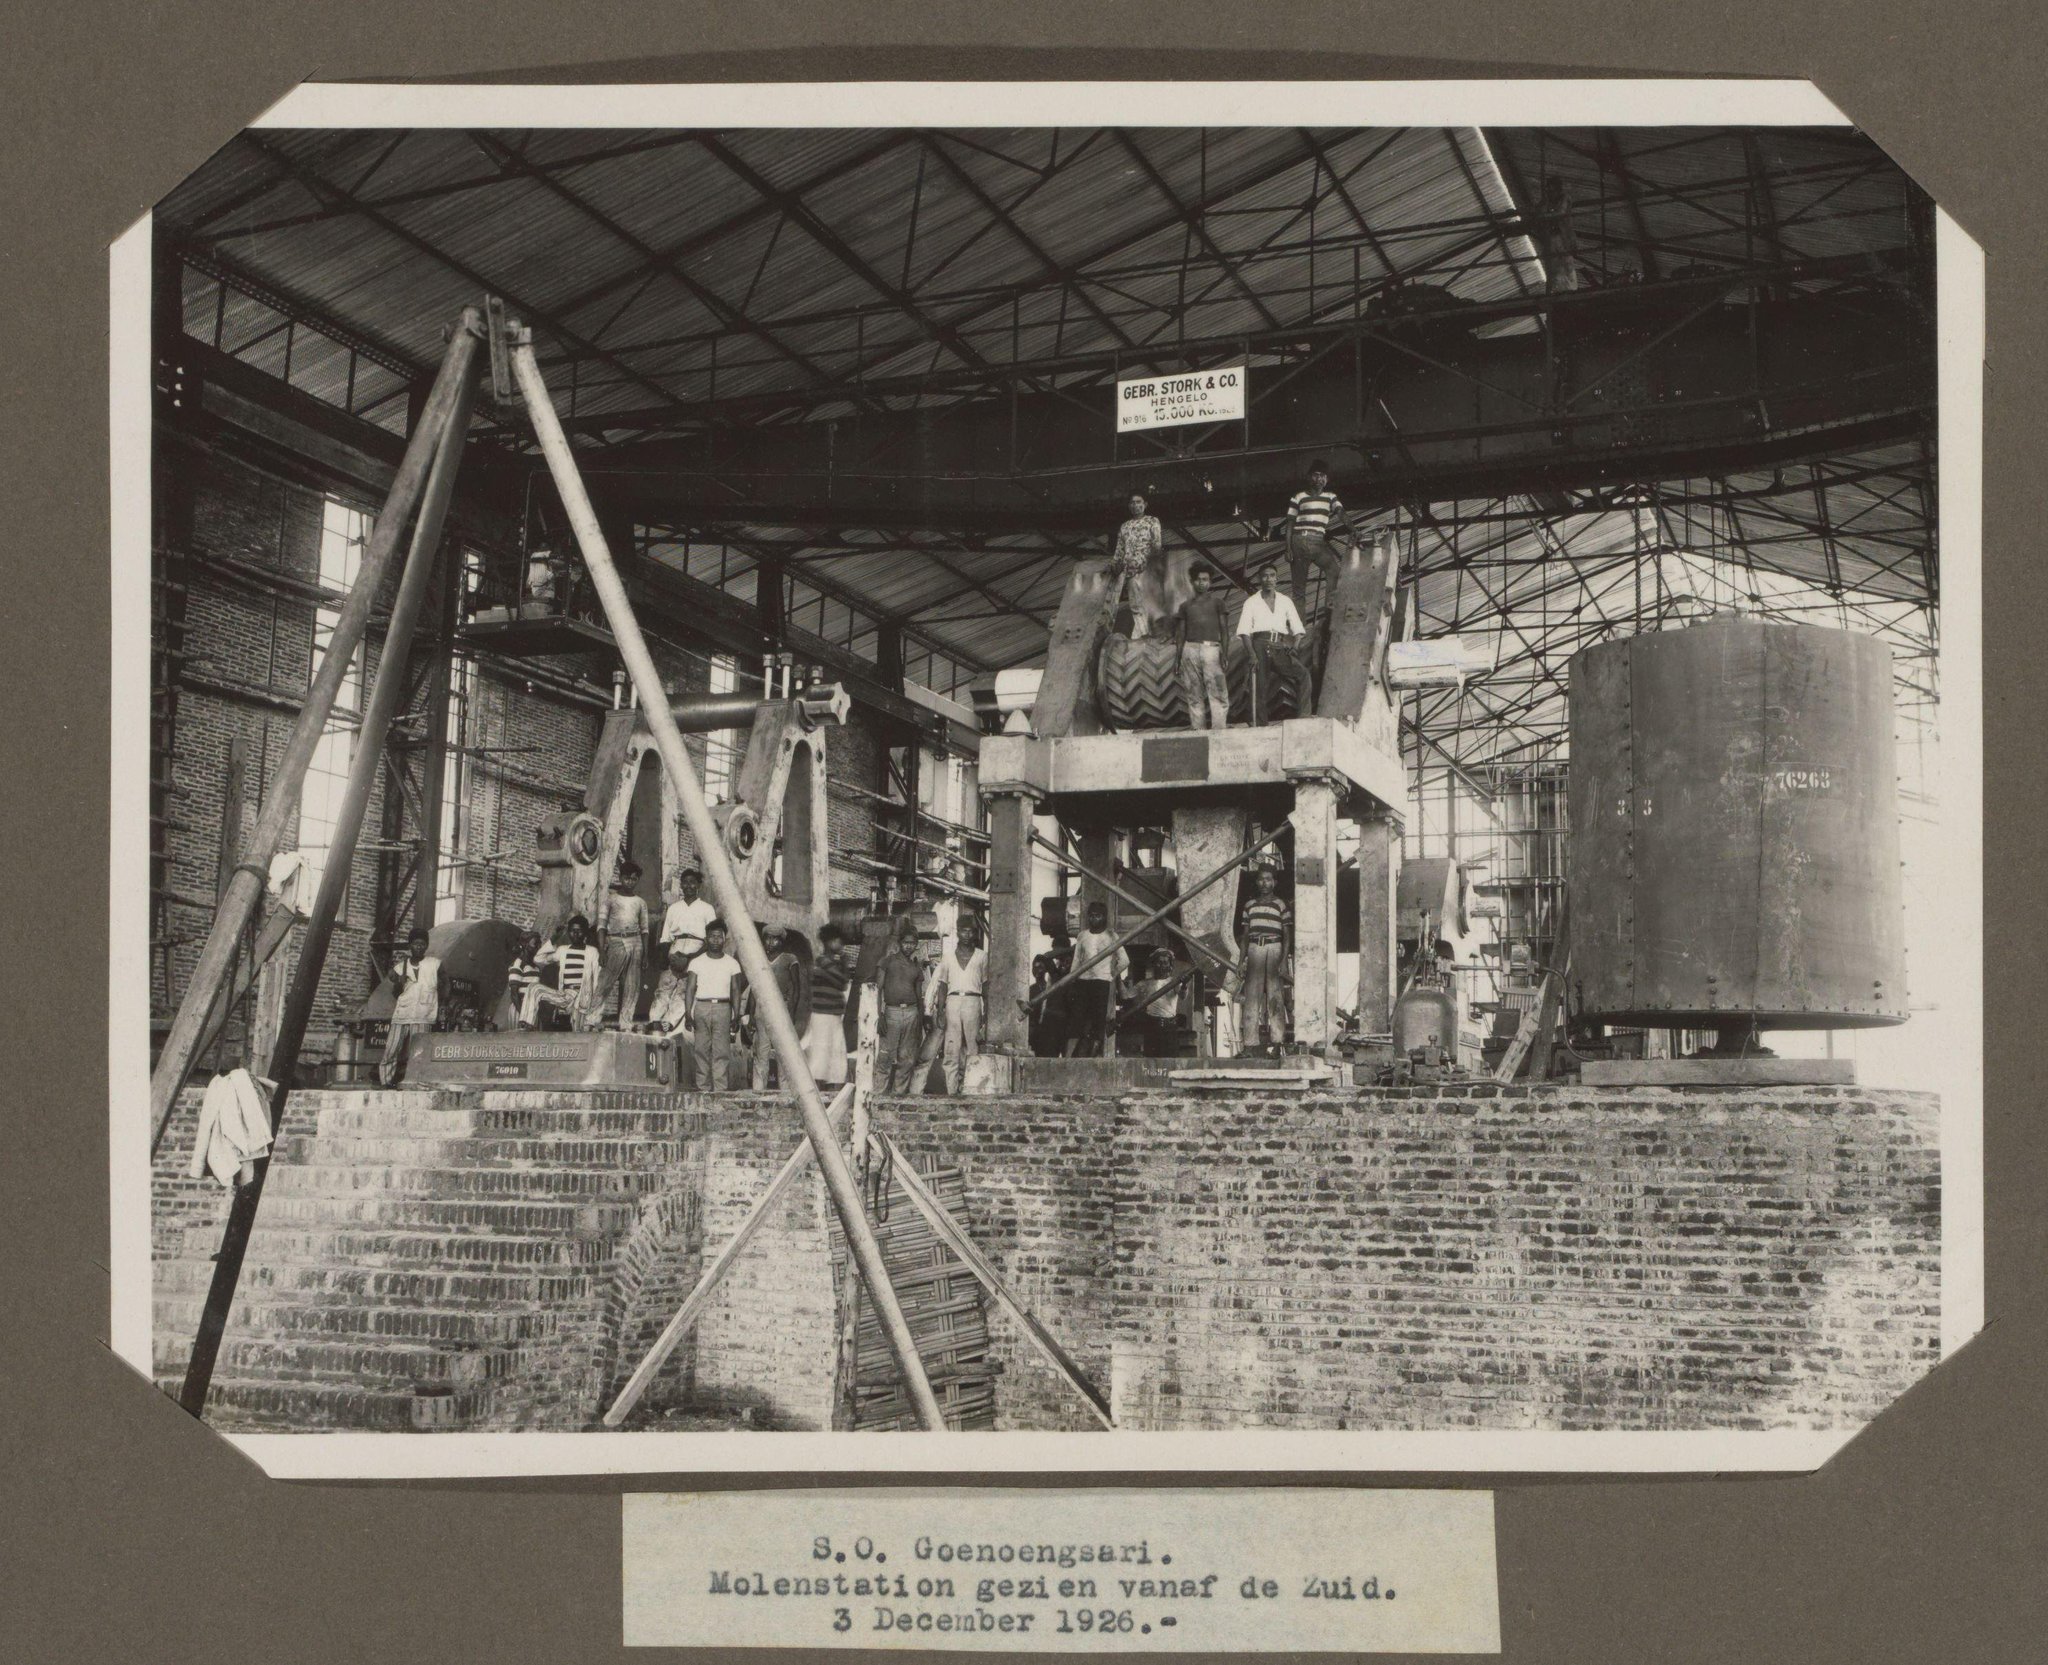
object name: photograph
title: S.O. Goenoengsari. Molenstation gezien vanaf de Zuid. 3 December 1926.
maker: Anonymous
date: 1912-1926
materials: photographic support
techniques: gelatin silver print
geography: east java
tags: colonial system, trade-company, factory-interior, machine shop, making the overground structures (~ building activities), (non-fruit) products of plants or trees: sugarcane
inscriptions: inscription: ‘S.O. Goenoengsari. Molenstation gezien vanaf de Zuid. 3 December 1926.’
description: Inrichting van het molenstation met de nieuwe machines van Gebroeders Stork & Co. uit Hengelo. Javaanse bouwvakkers poserend op de machines, 3 december 1926. Onderdeel van het fotoalbum met foto's van de opbouw van de suikerfabriek te Goenoengsari op Oost-Java door de Handels Vereniging Amsterdam 1926-1927.